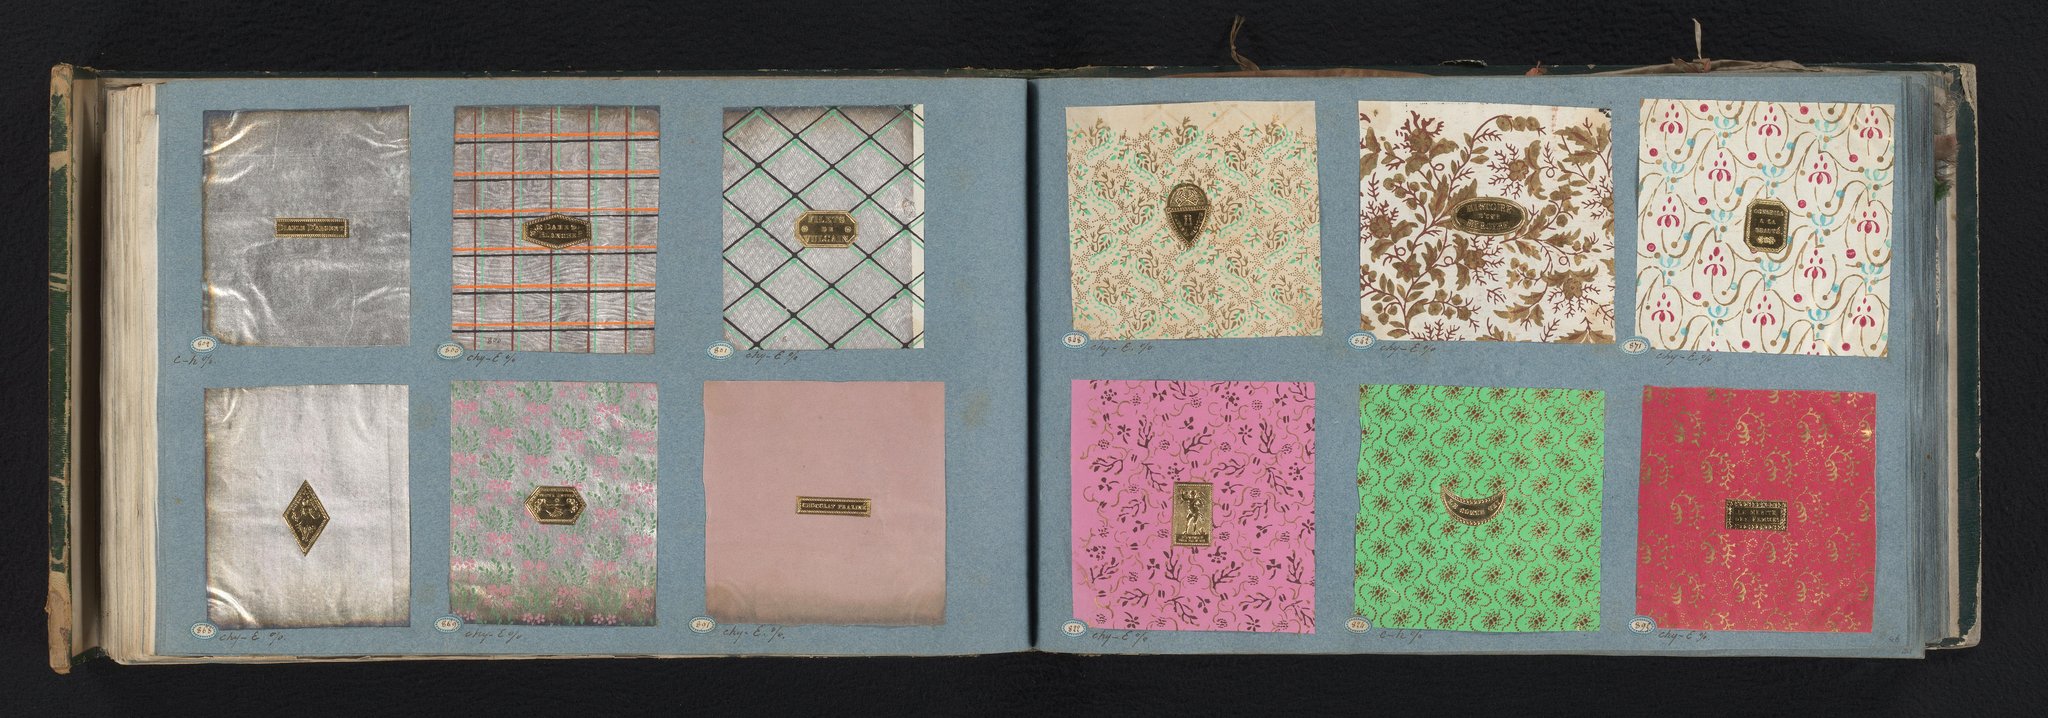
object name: sample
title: Twee bladzijden met stalen van sitspapier met goudkleurige labels met teksten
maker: Anonymous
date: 1830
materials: gold leaf, ink, paper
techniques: printing block, manufacturing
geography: france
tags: ornaments ~ art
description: Twee bladzijden met 12 opgeplakte stalen van sitspapier en zilverkleurig metaalpapier met labels met Franse teksten in goudkleurig metaalpapier. Alle stalen voorzien van etiketten met nummers (809-895) en handgeschreven codes. Onderdeel van het stalenboek geschonken door de dames Van Rijn, vermoedelijk van een Franse papierfabrikant van luxe papieren, of diens vertegenwoordiger in Nederland, ca. 1830.